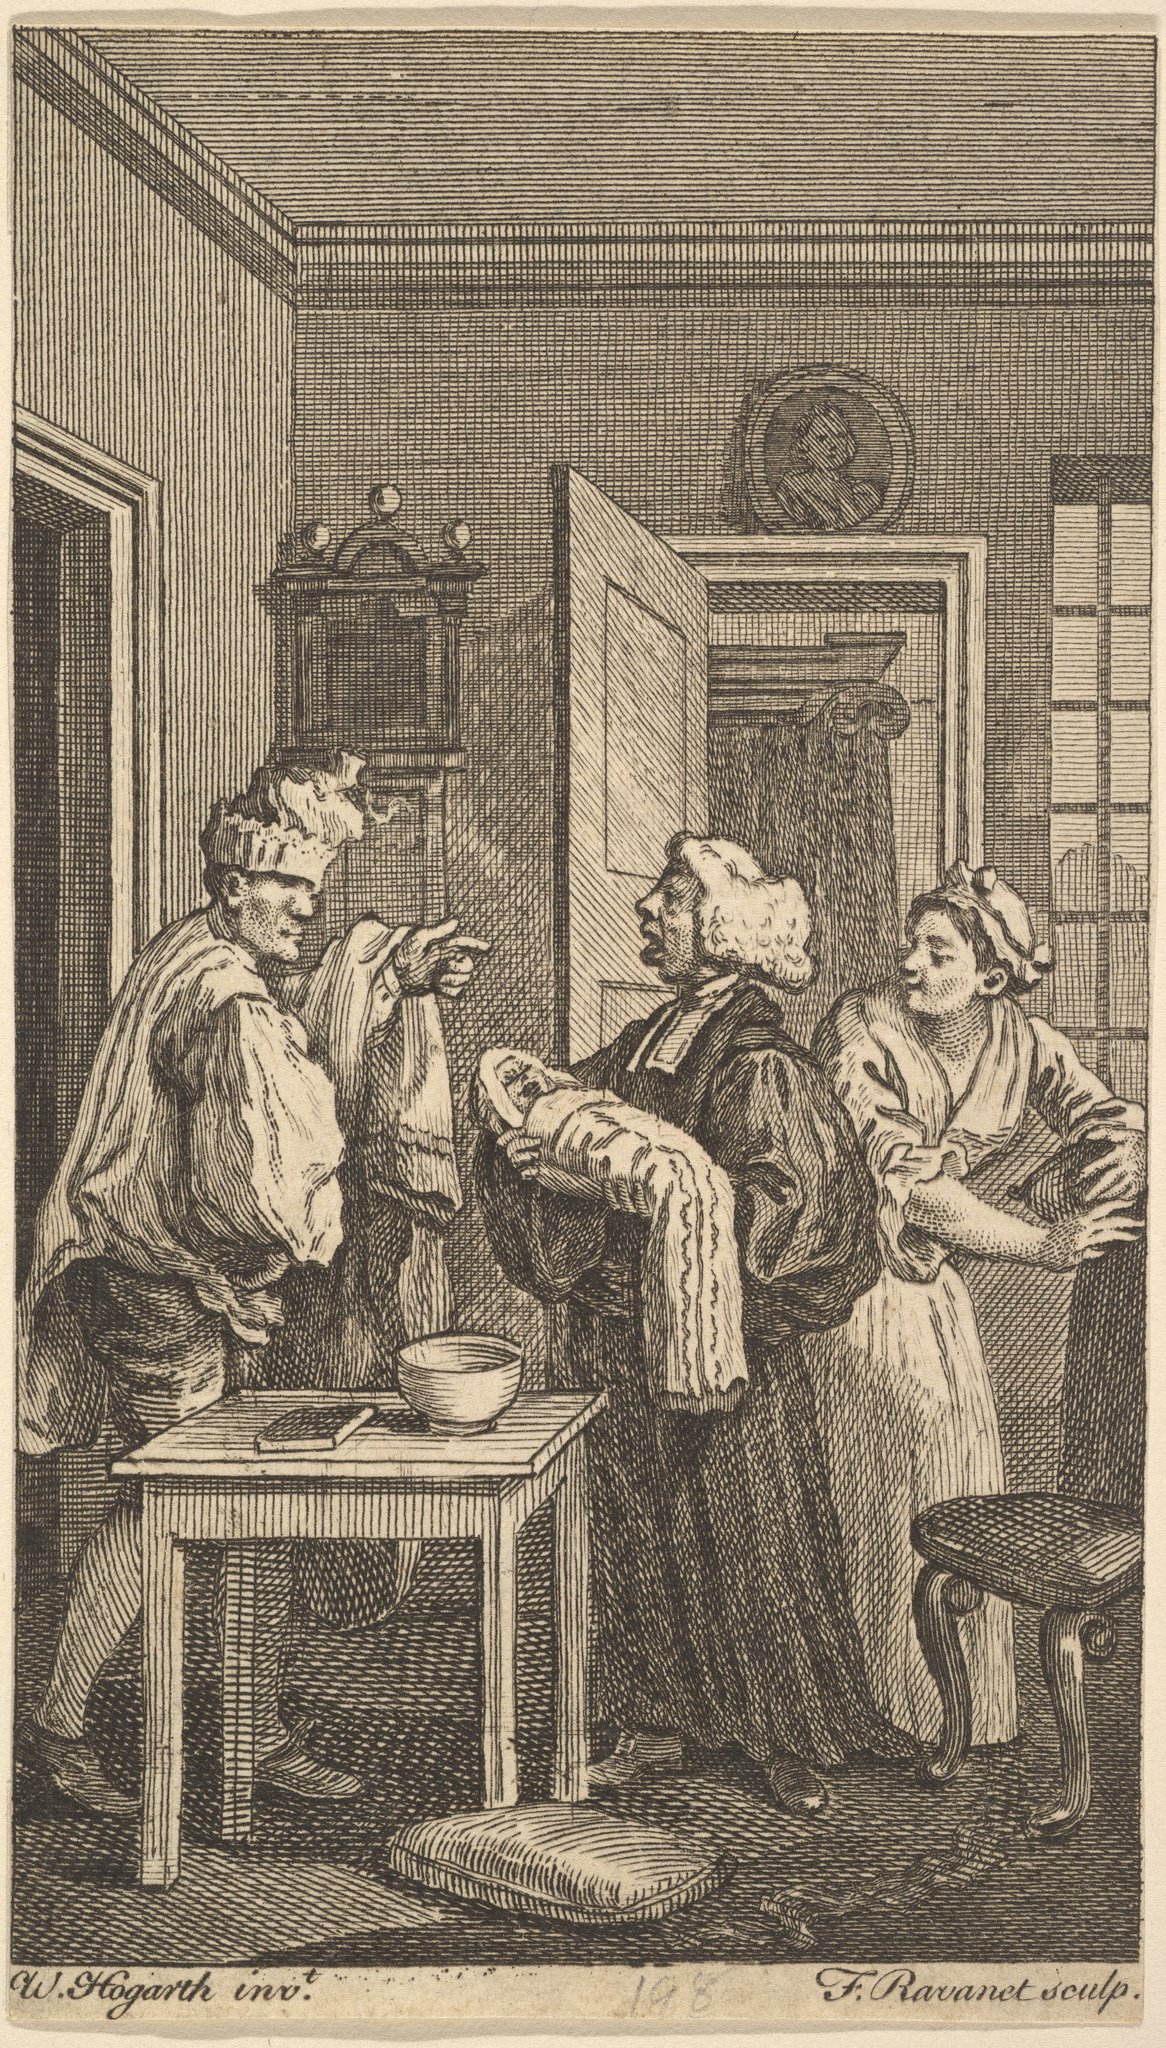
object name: print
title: "Tristram Shandy," Volume 4, page 112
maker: simon francis ravenet, the elder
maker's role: artist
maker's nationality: french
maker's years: 1706-1774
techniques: engraving, etching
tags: infants,men,women